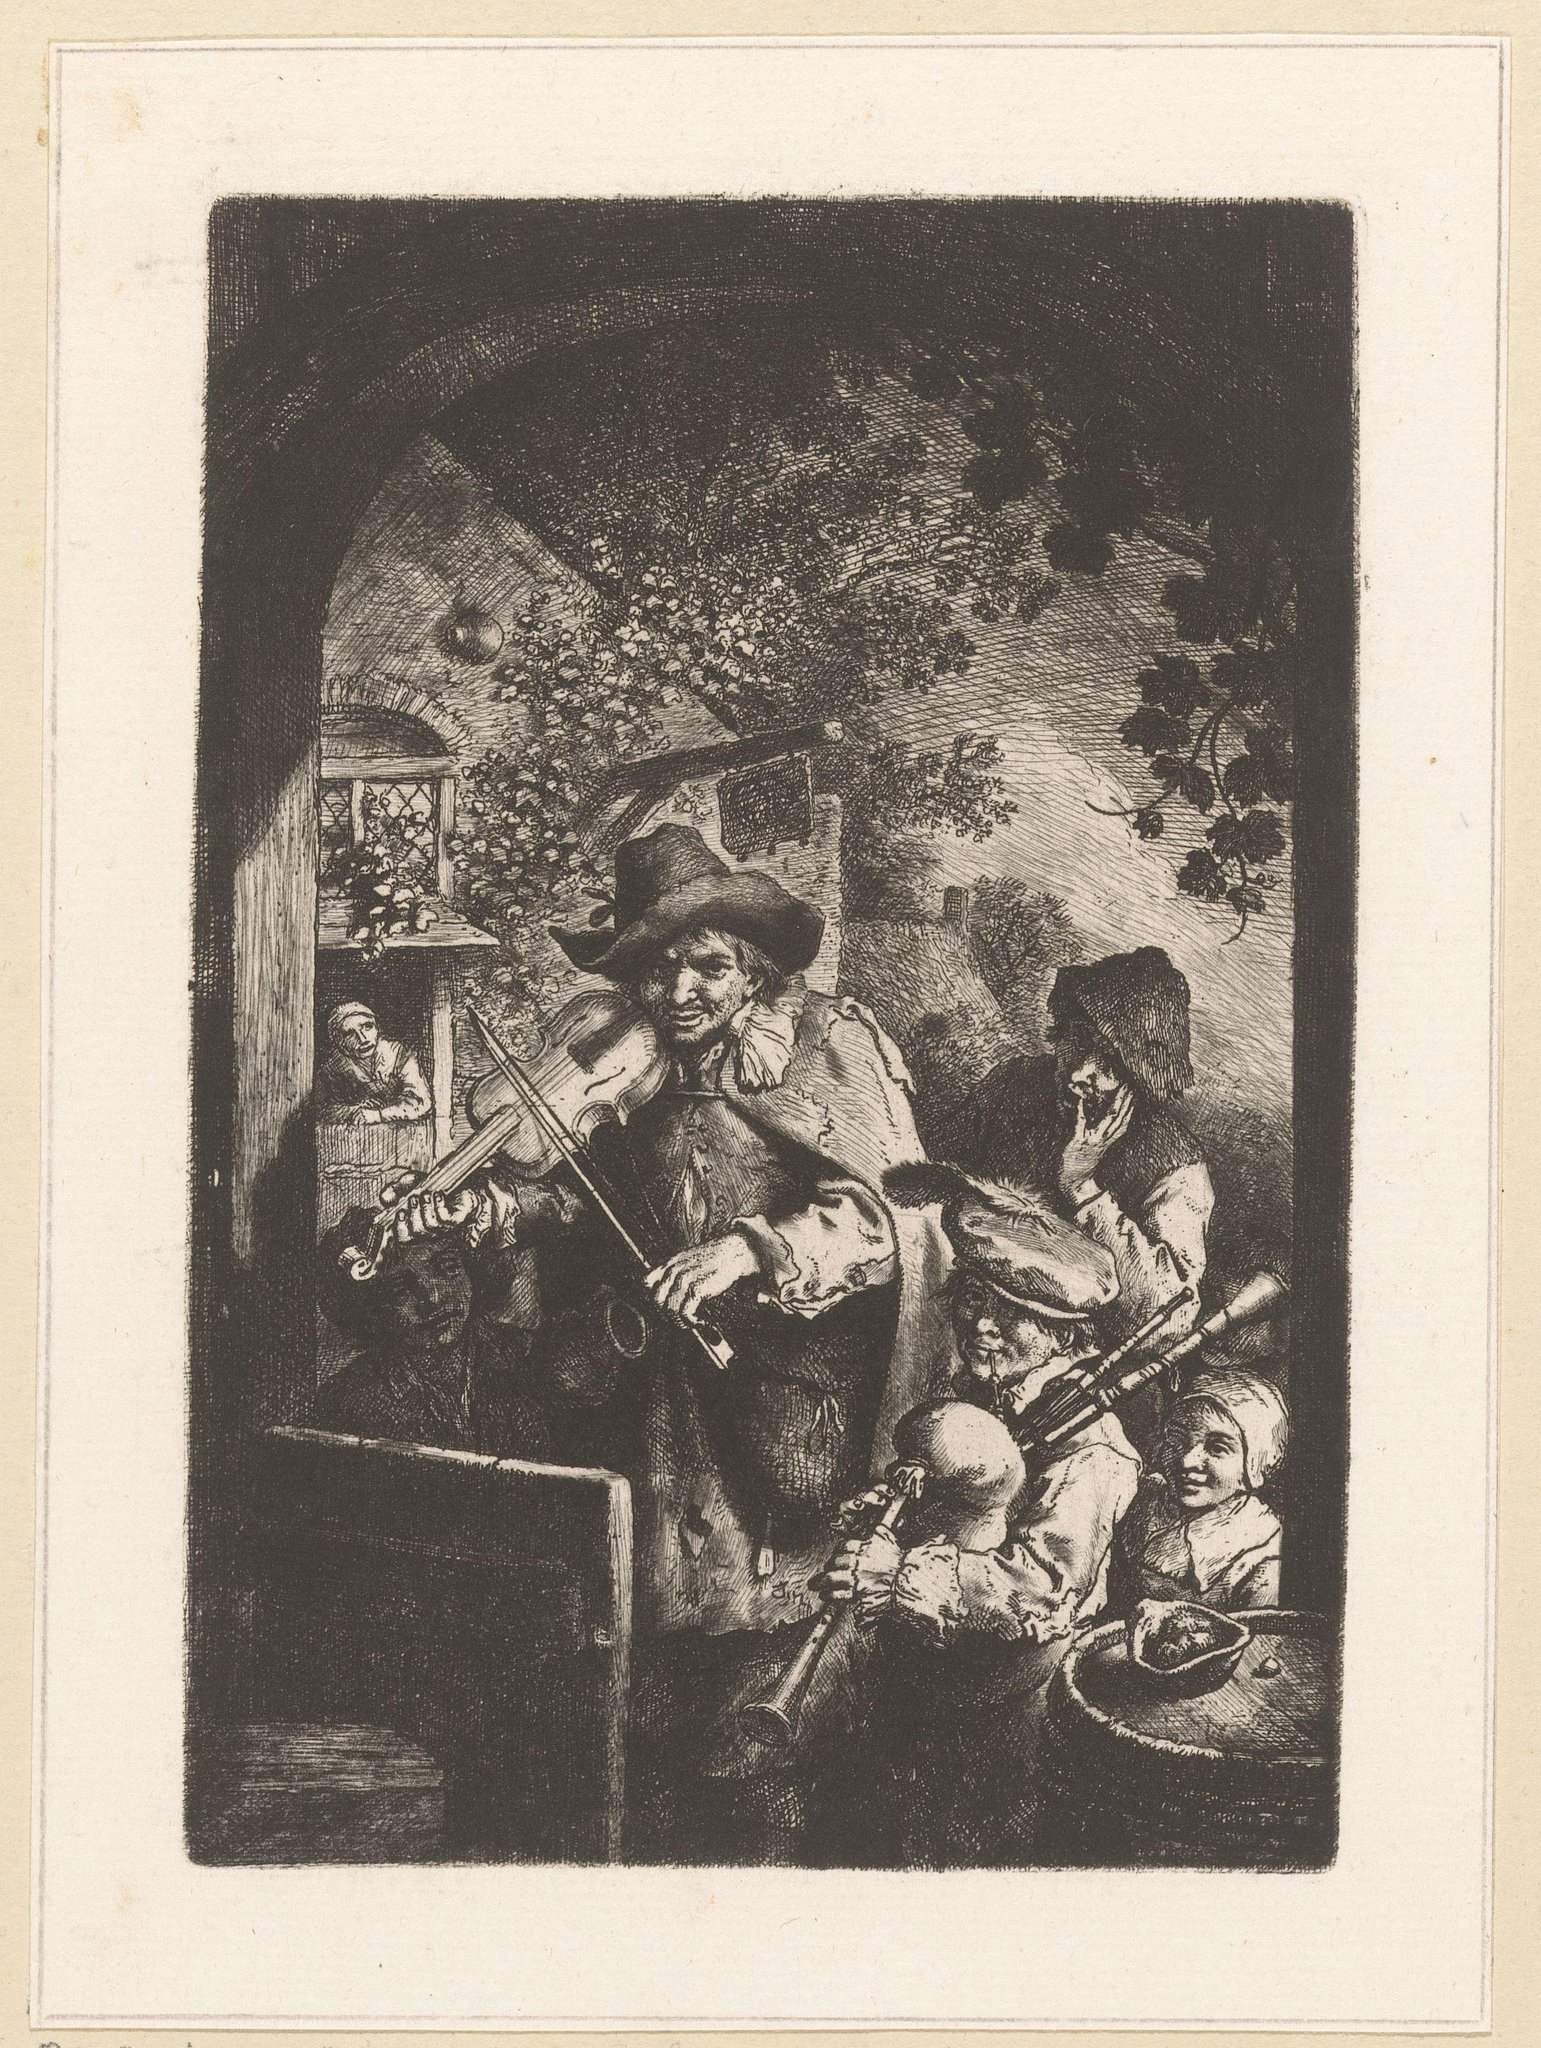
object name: print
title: Muzikanten in deuropening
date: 1722-1774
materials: paper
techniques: etching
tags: city-view, and landscape with man-made constructions, open door, making music; musician with instrument - cc - out of doors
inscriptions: collector's mark: Lugt 240